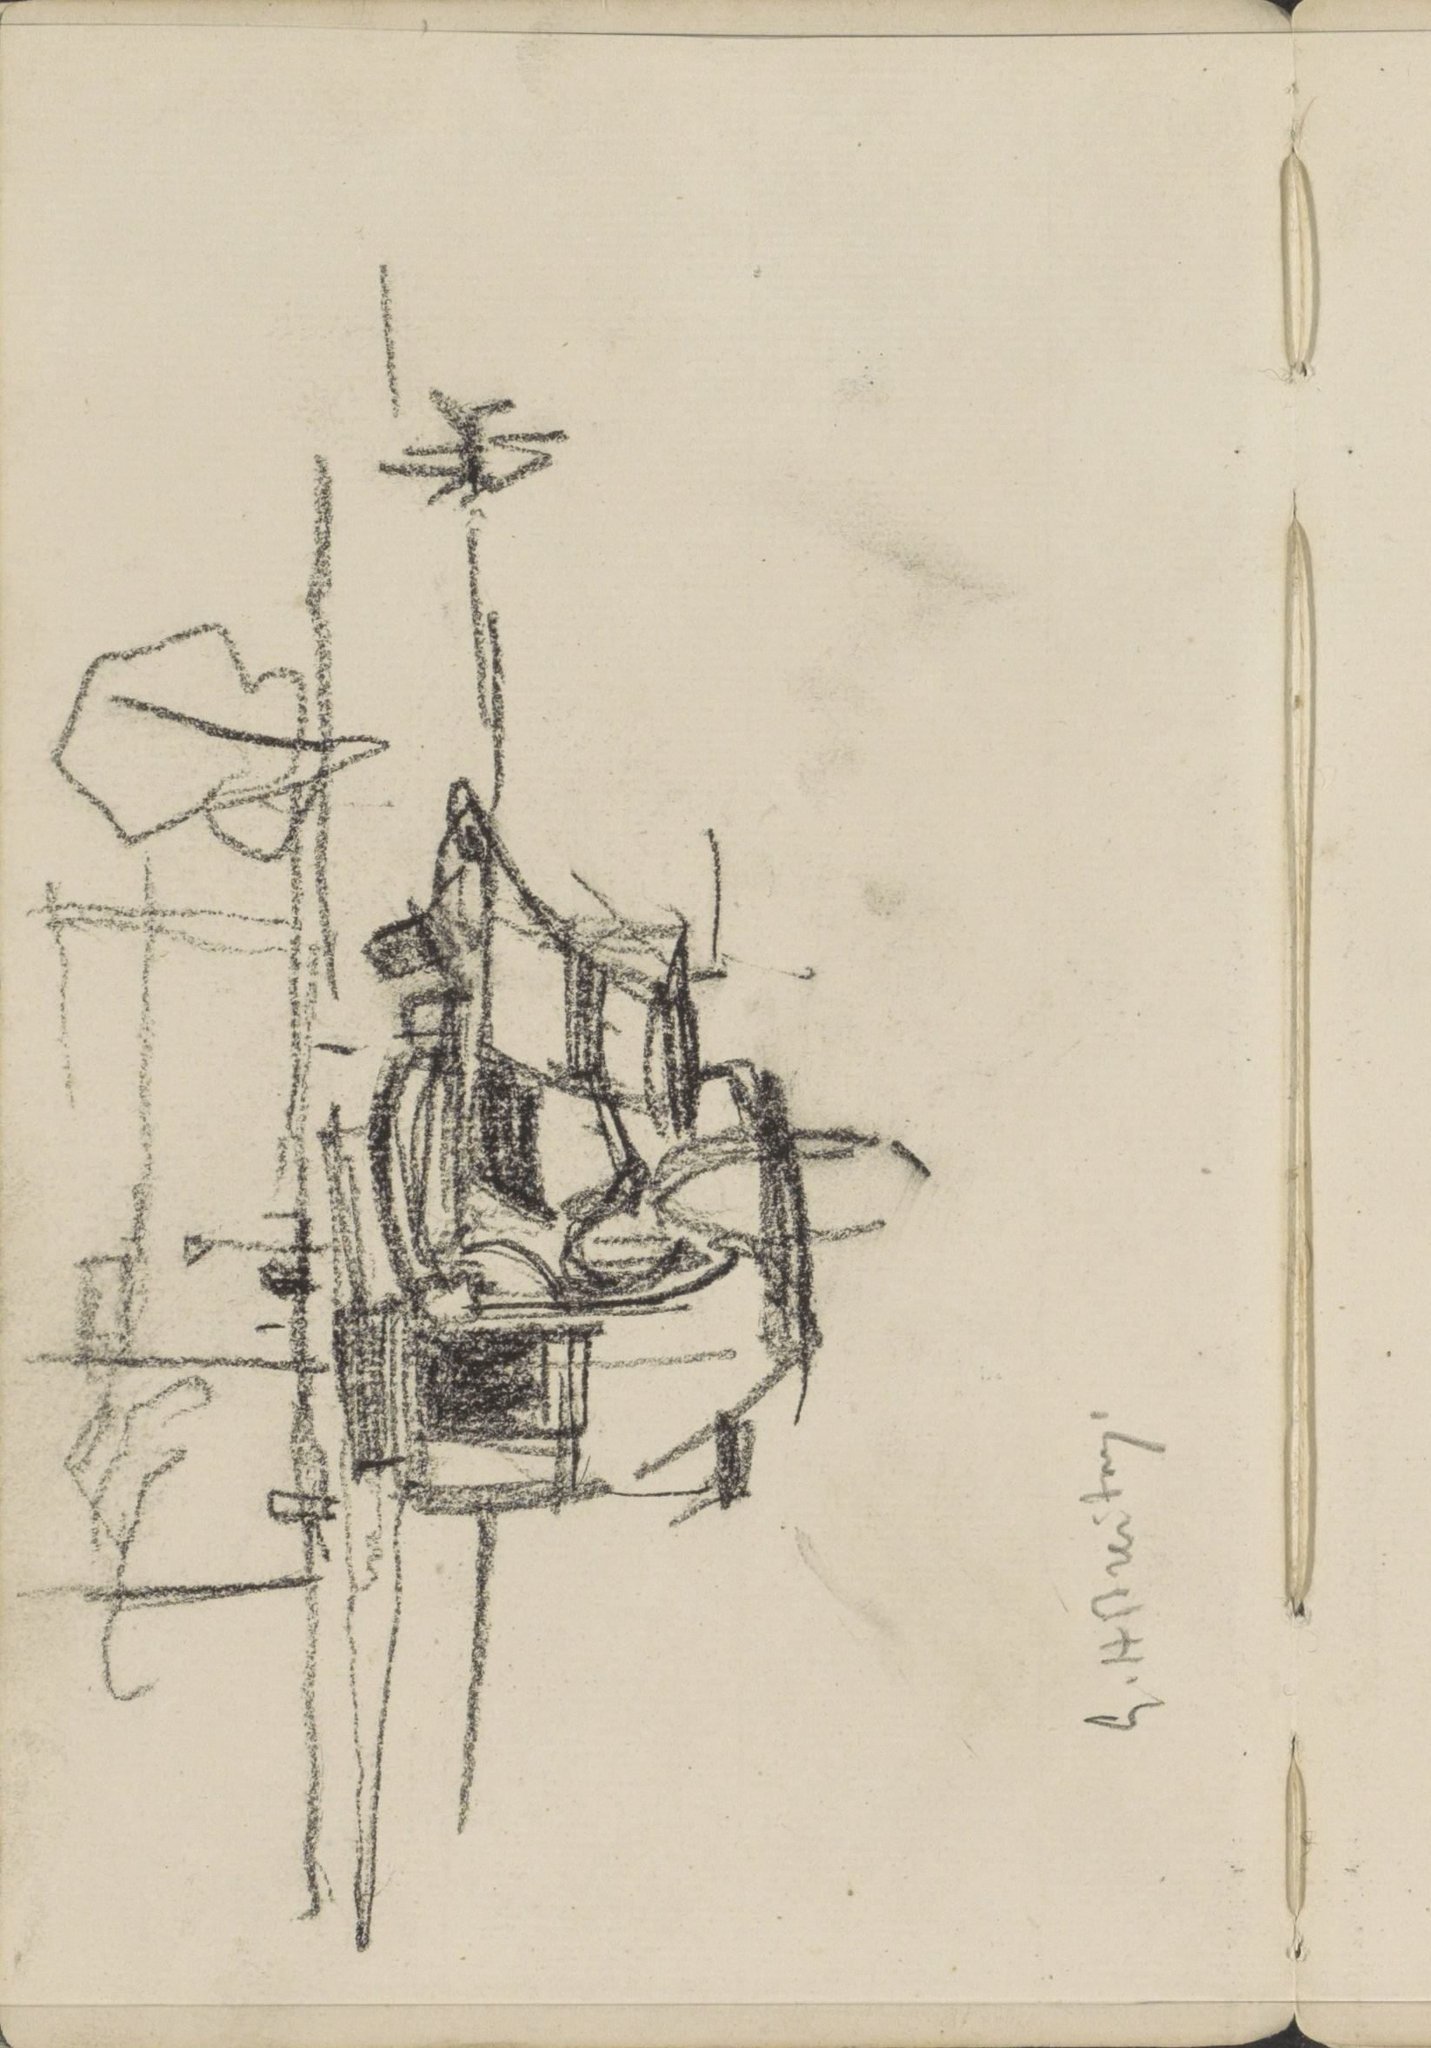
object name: sketchbook leaf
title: Rijtuig in een landschap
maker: george hendrik breitner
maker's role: draughtsman, painter, print maker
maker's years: 1857-1923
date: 1886-1903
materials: chalk, paper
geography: amsterdam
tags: landscapes, four-wheeled, animal-drawn vehicle, e.g.: cab, carriage, coach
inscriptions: signature: ‘G.H Breitner.’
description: Pagina 3 uit een schetsboek met 16 bladen.